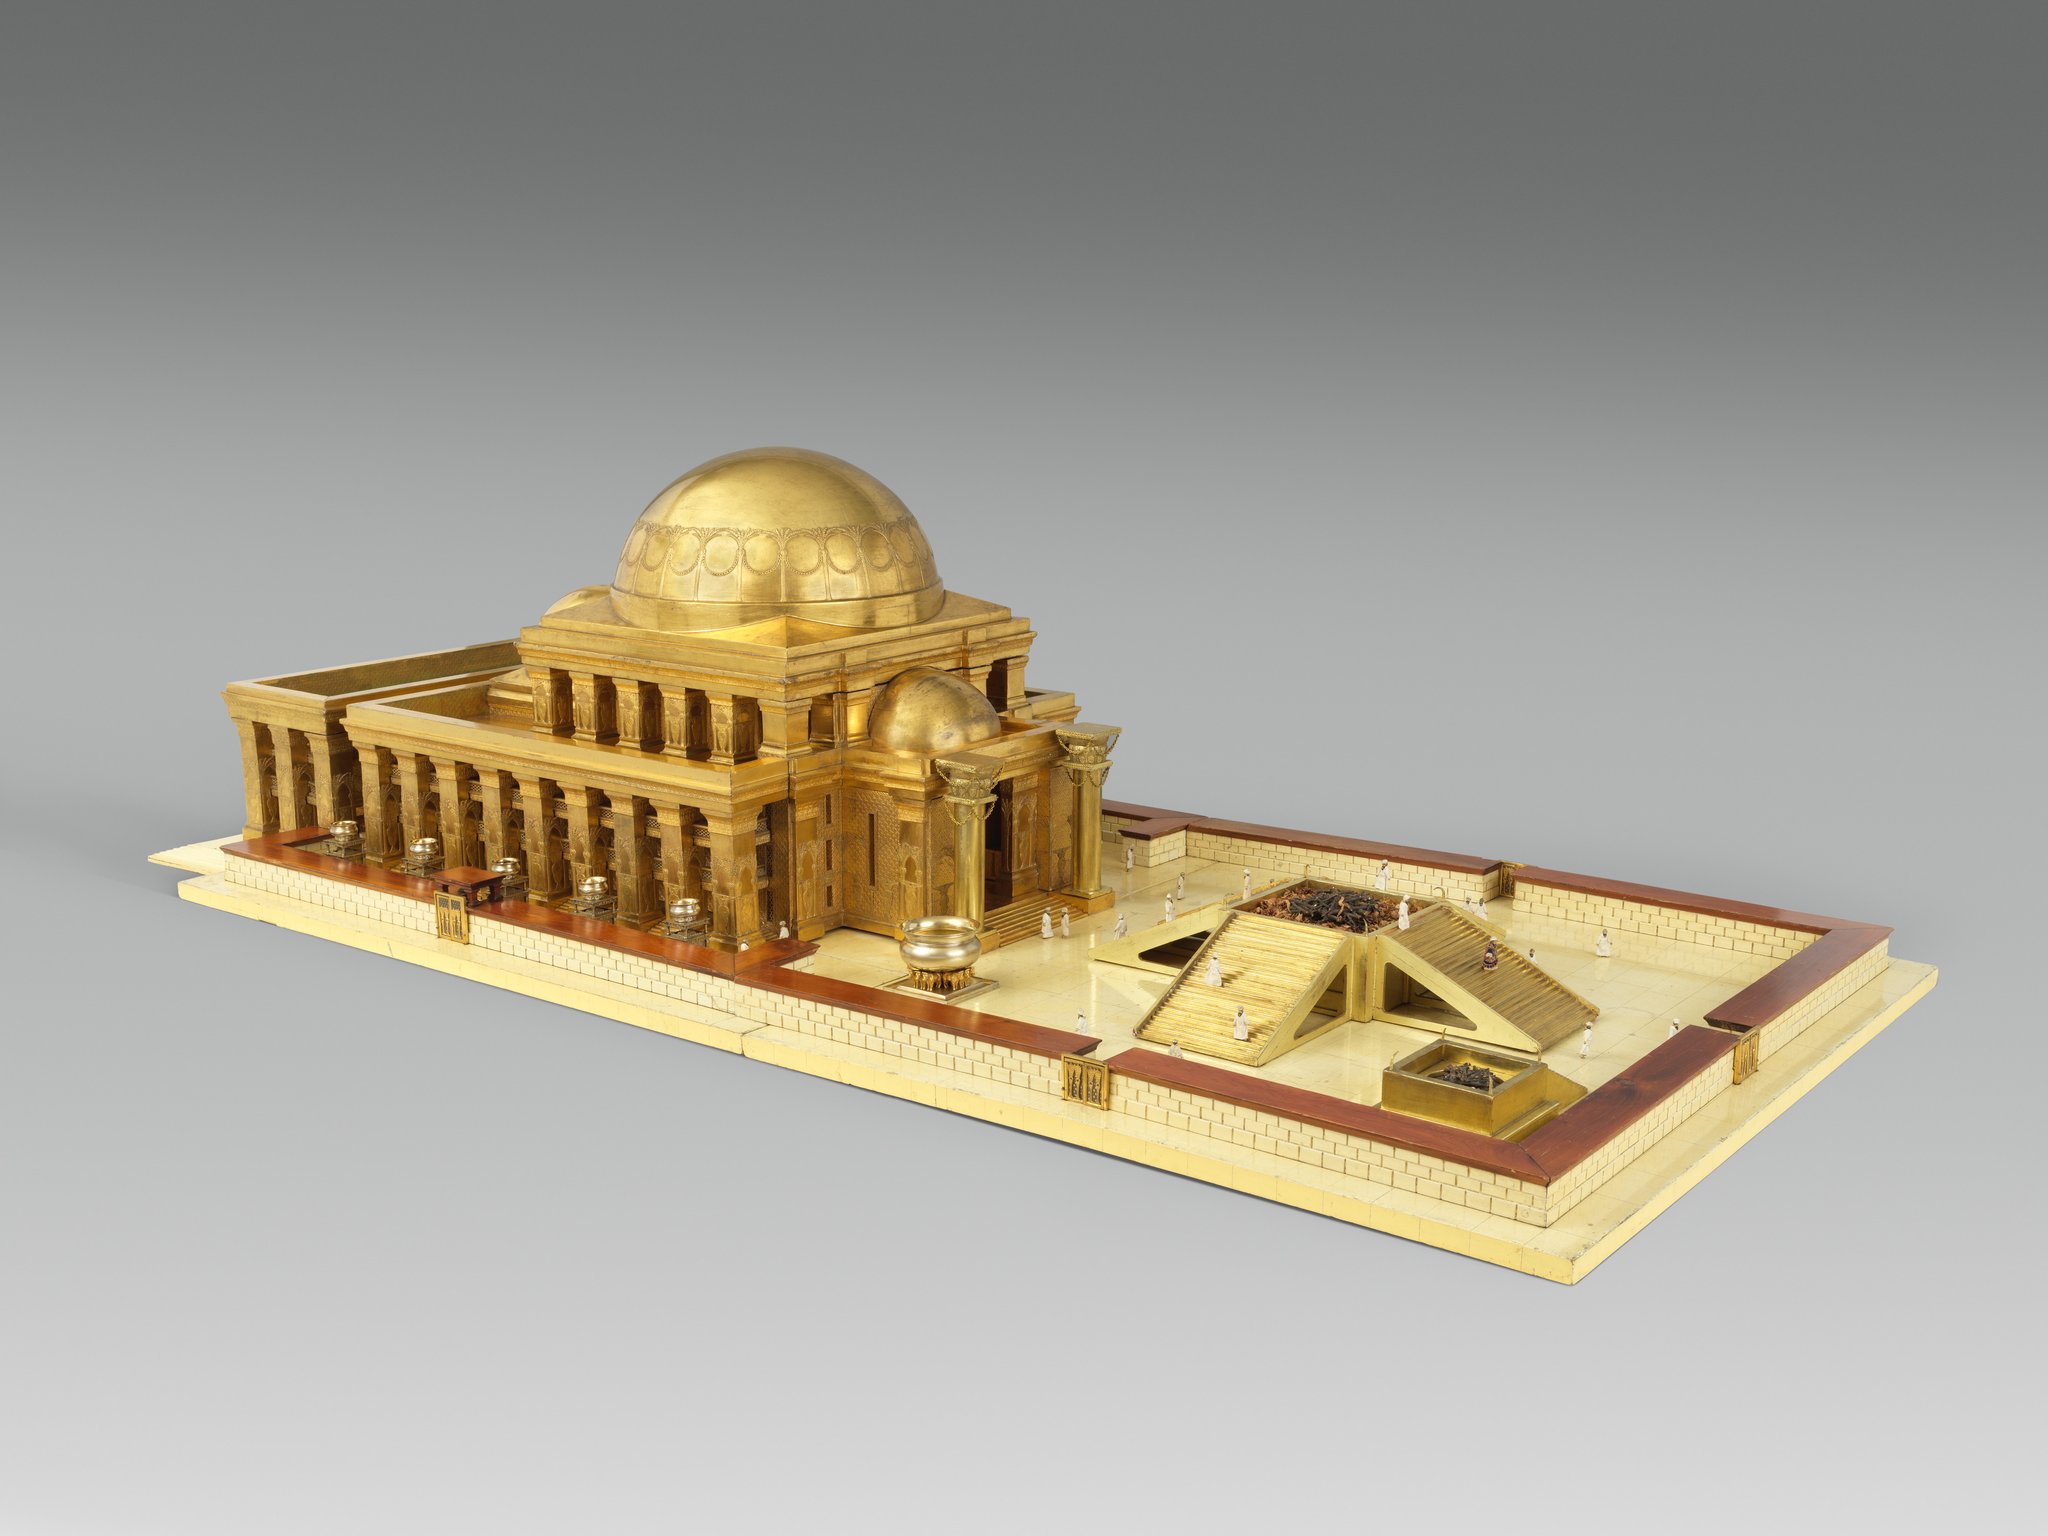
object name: architectural model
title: Architectural model of the temple of King Solomon in Jerusalem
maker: thomas newberry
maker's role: designer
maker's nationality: british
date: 1883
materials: bronze, enamel, gilt silver, linen, wood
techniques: gilding